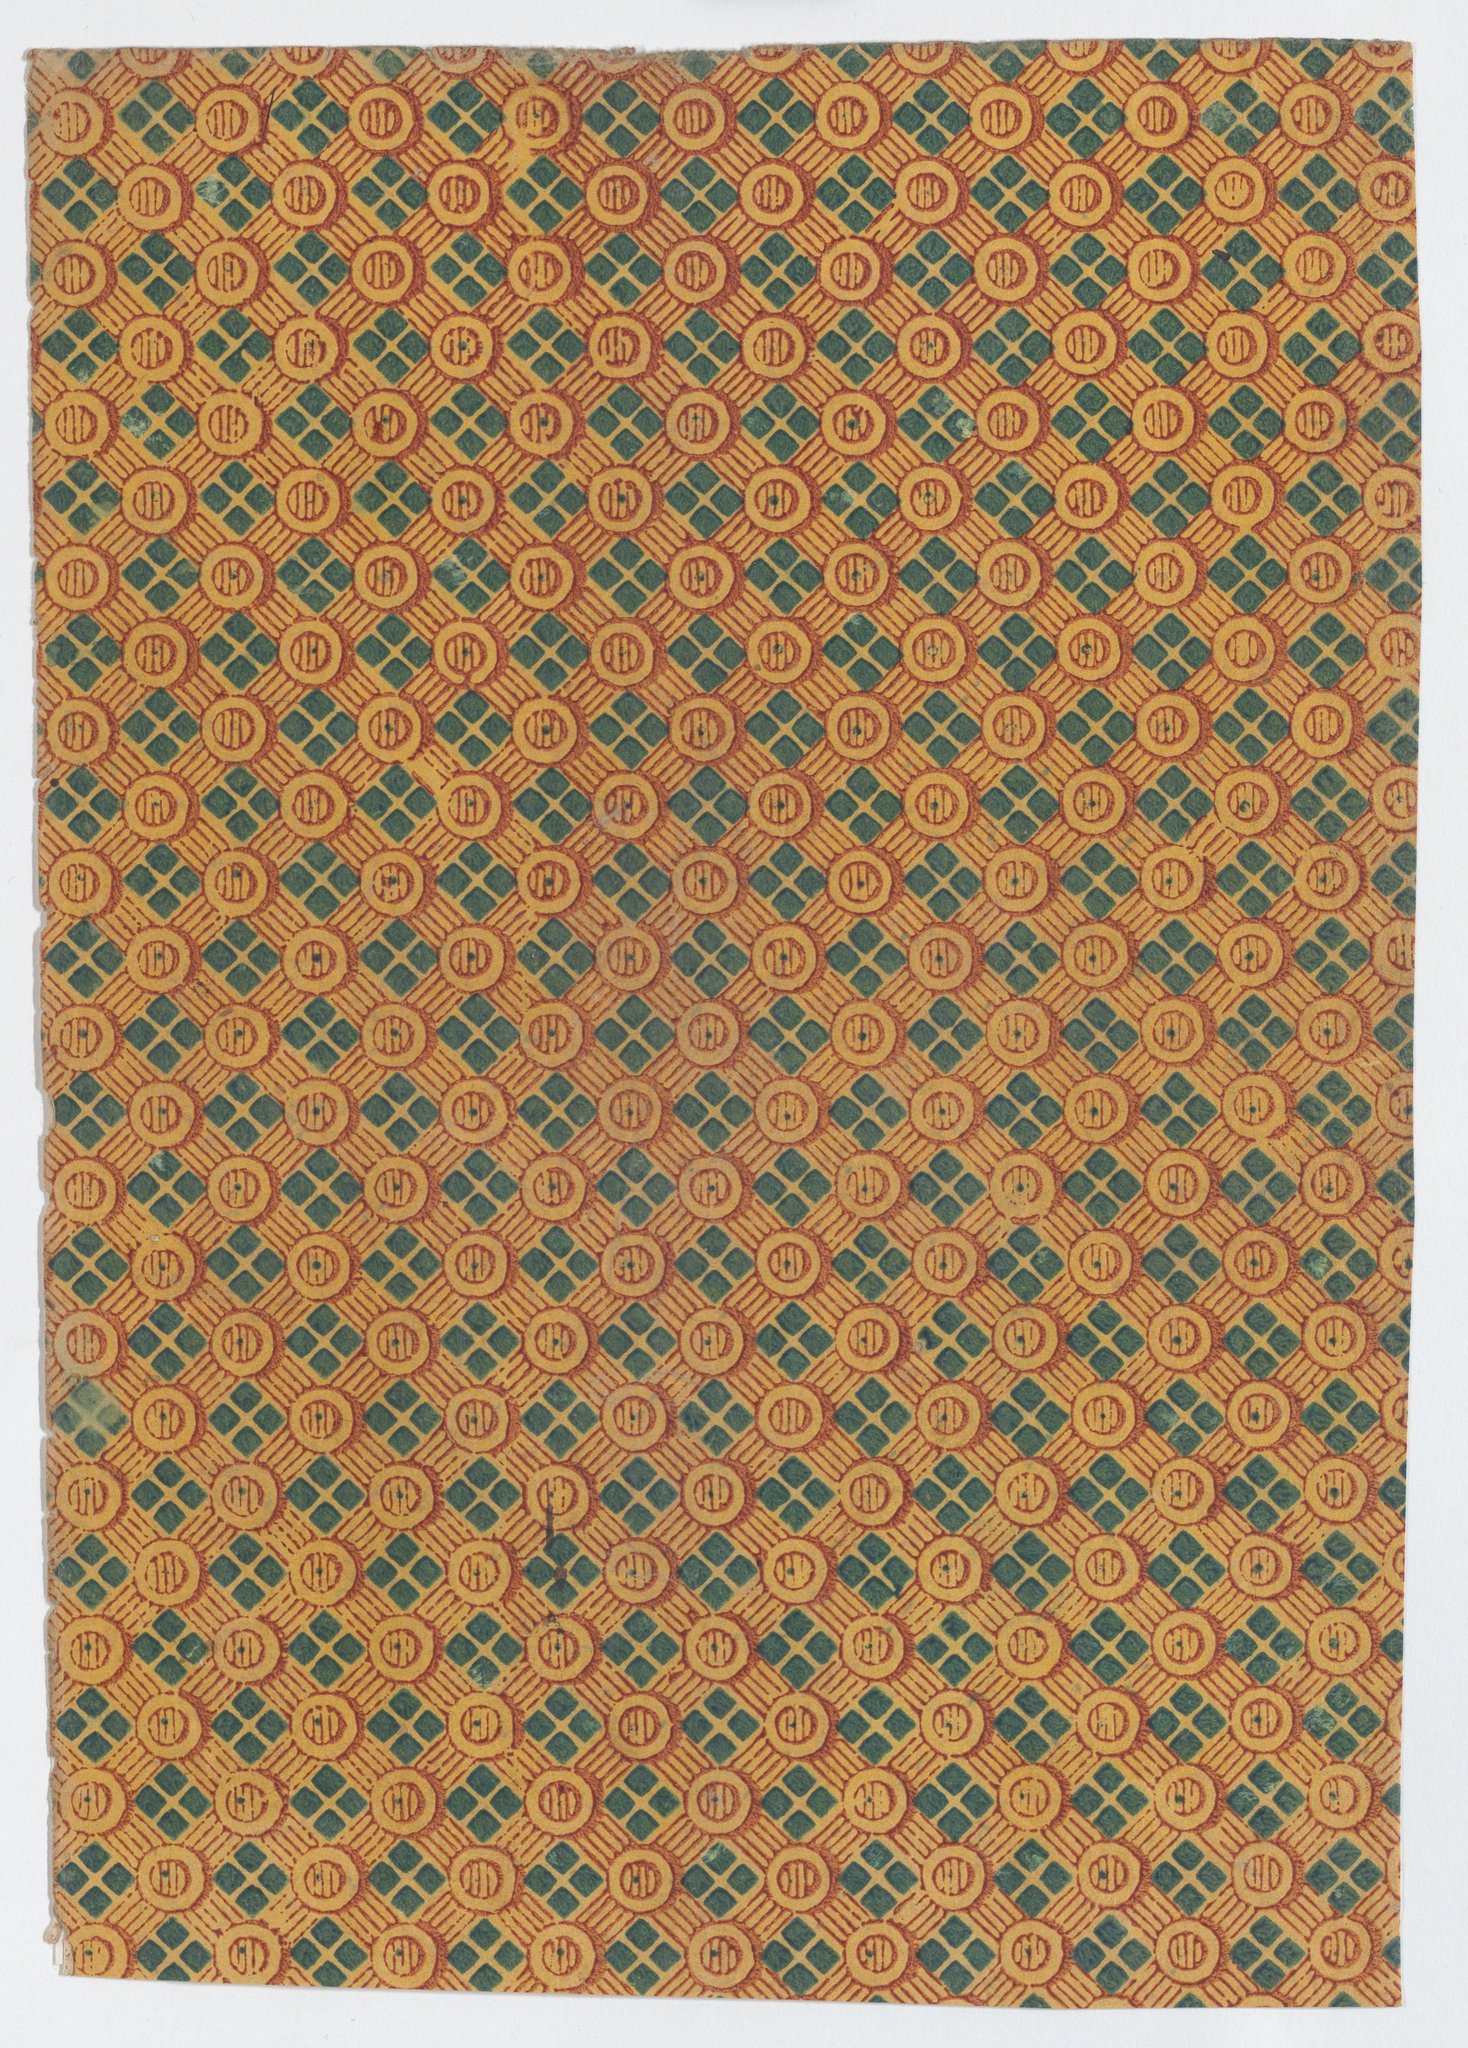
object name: print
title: Sheet with overall geometric pattern with striped circles and squares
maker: Anonymous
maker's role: artist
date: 1801-1900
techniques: relief print